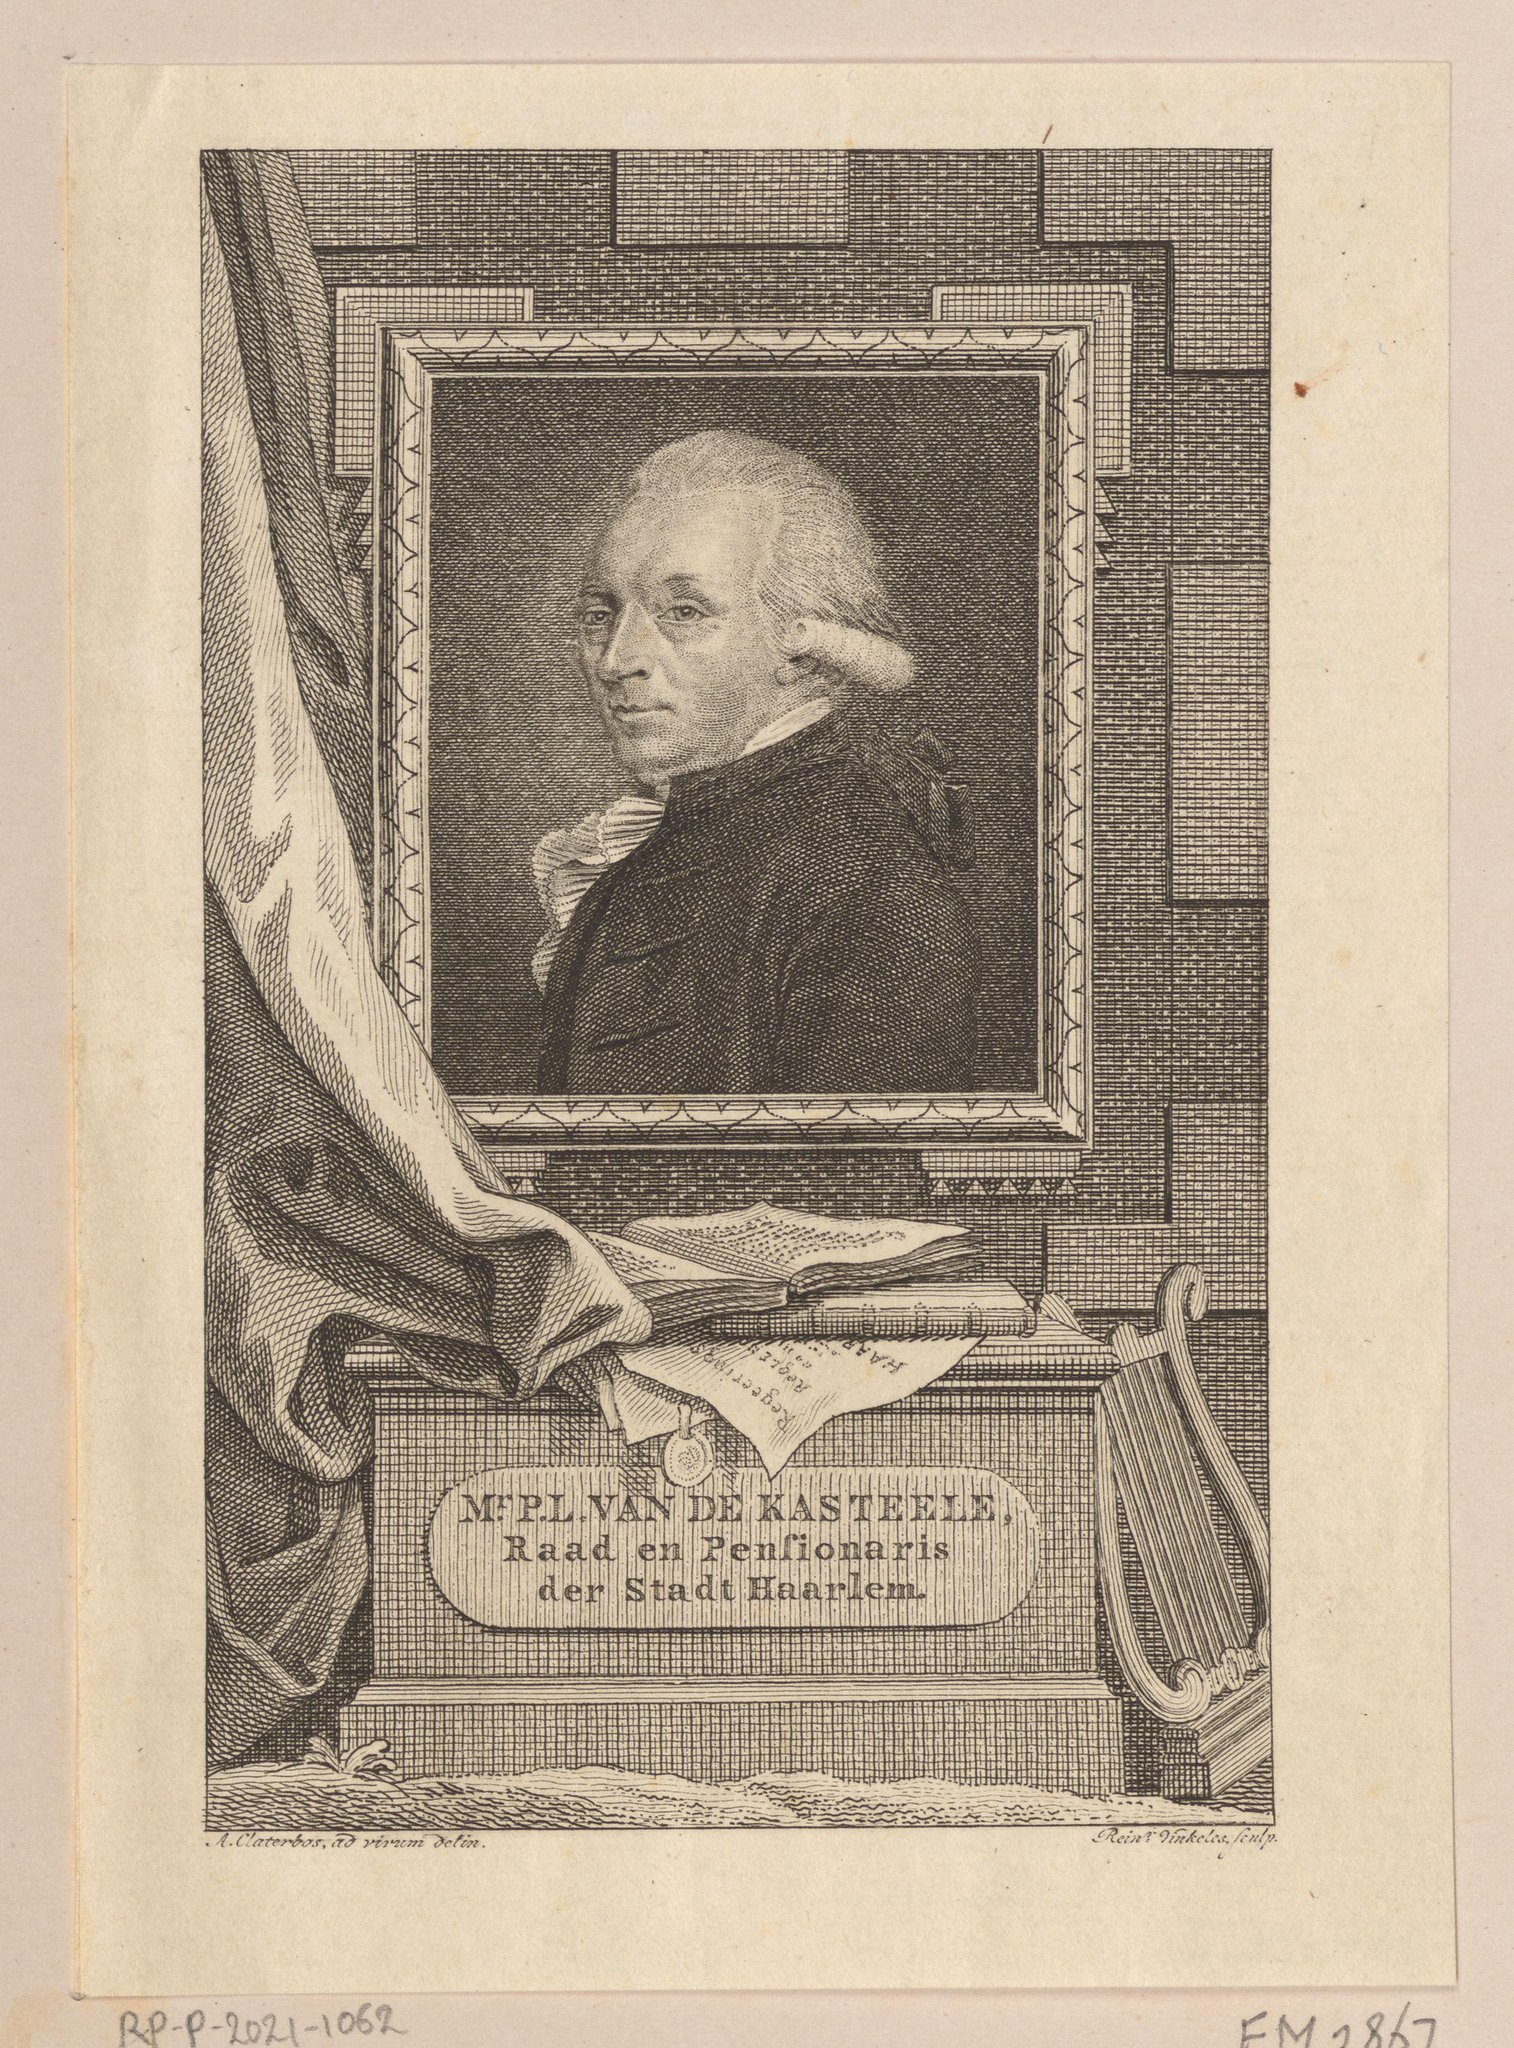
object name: print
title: Portret van Pieter Leonard van de Kasteele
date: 1790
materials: paper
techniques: engraving, etching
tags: the hague, pieter leonard van de kasteele, historical persons, harp, book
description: Prent mogelijk uit: Wagenaar, Jan. Vaderlandsche historie, vervattende de geschiedenissen der vereenigde Nederlanden (...). Amsterdam: Johannes Allart, 1790, dl. 5.